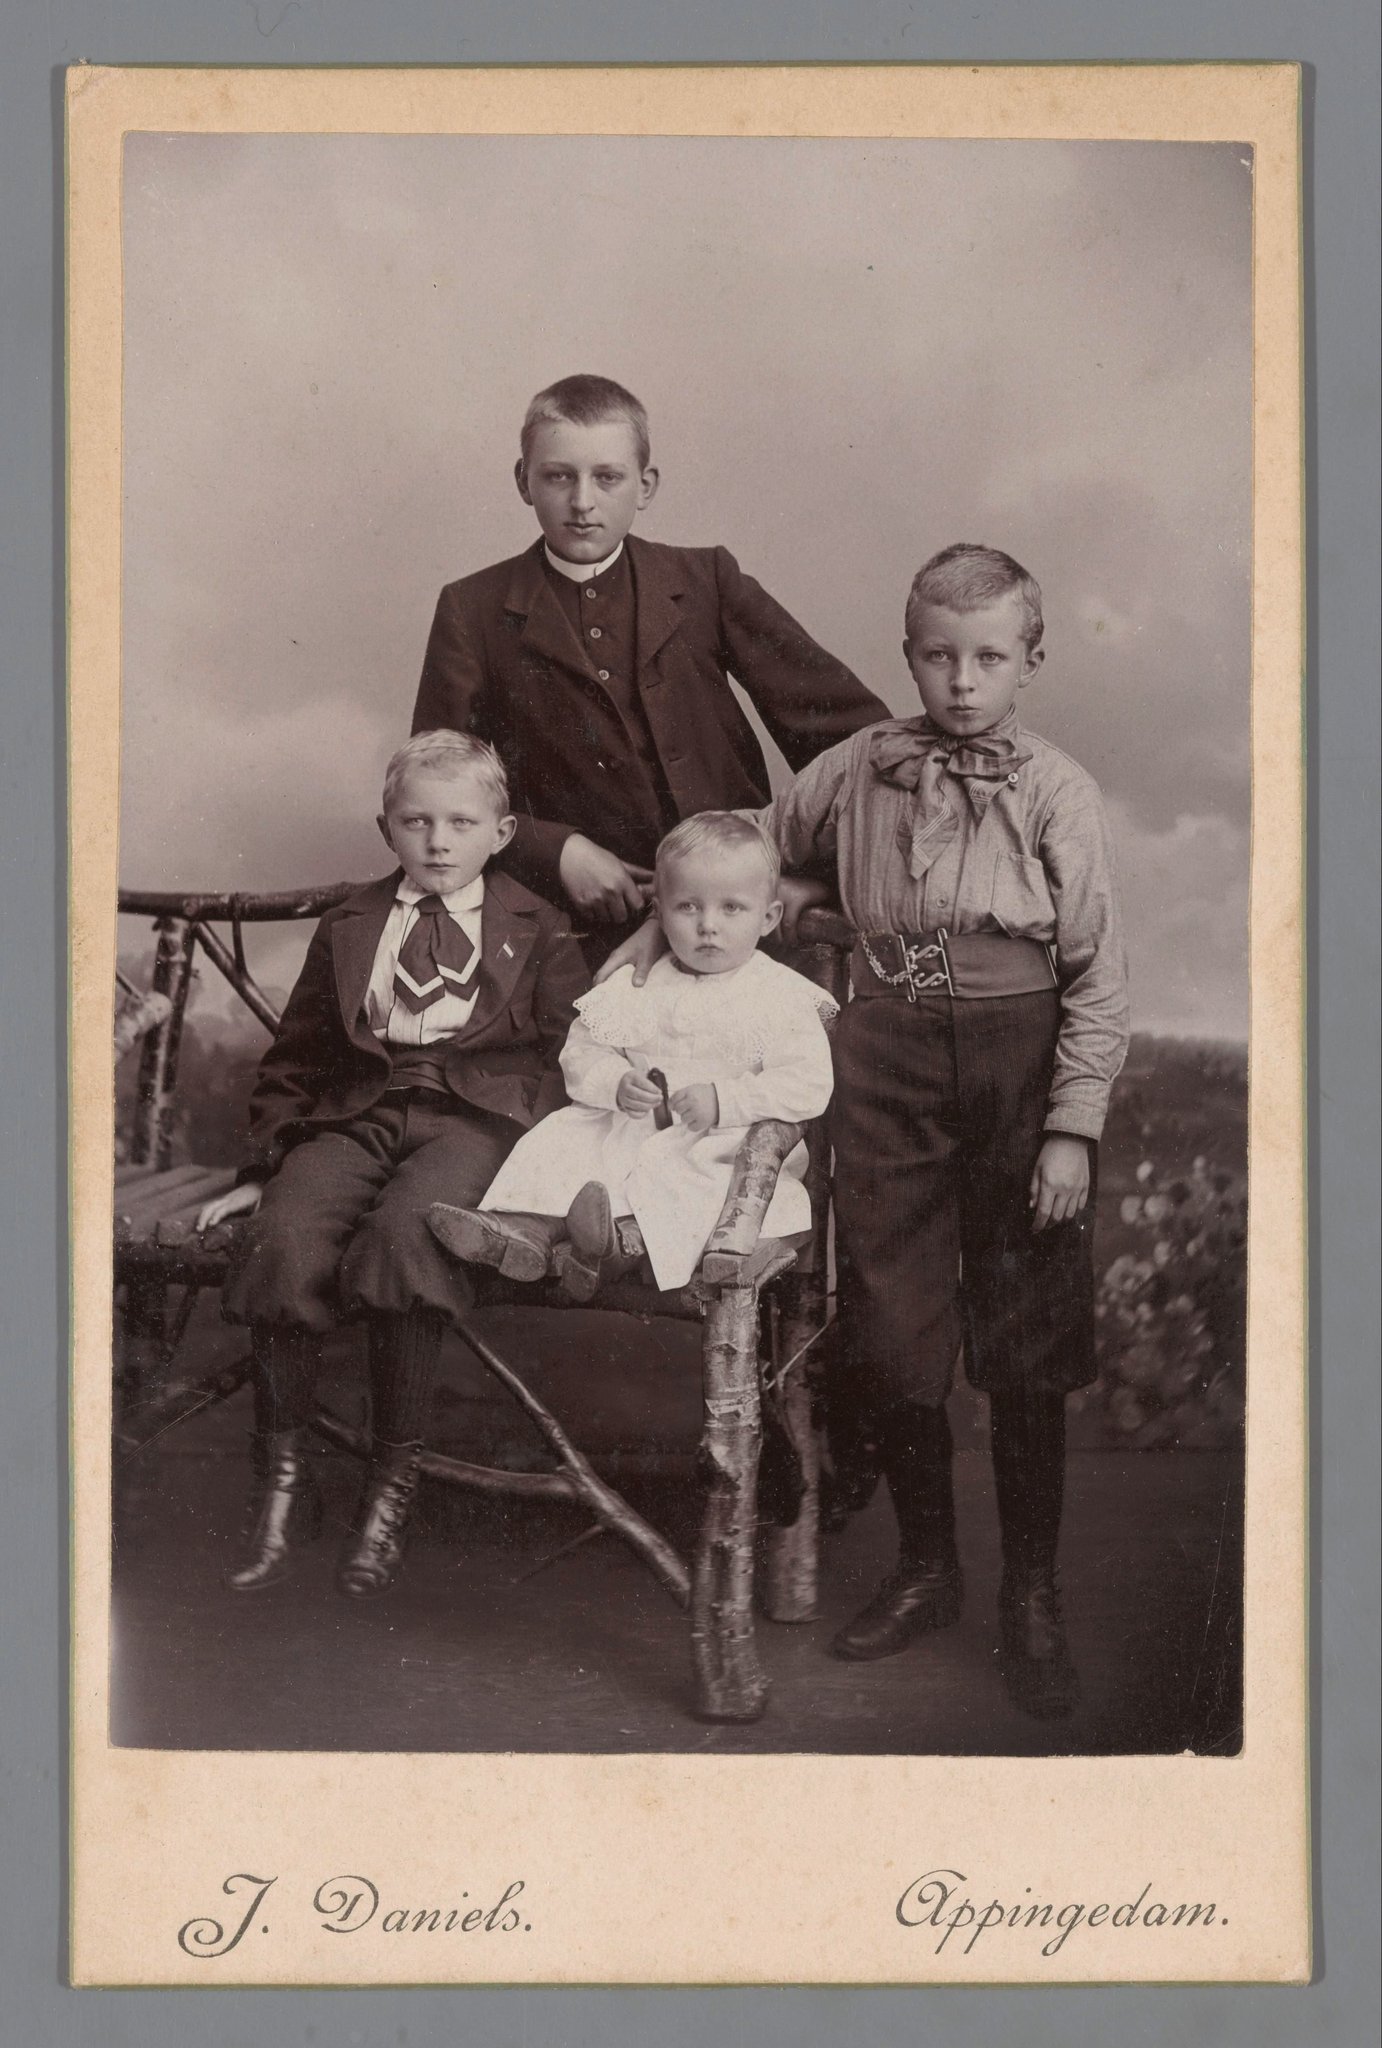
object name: cabinet photograph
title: Portret van vier onbekende kinderen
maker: jurre daniels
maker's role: draughtsman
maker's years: 1871-1928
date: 1870-1900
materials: cardboard, photographic support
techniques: collodion silver print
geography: appingedam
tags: studio requisites ~ photographer, children (first degree family relationships)